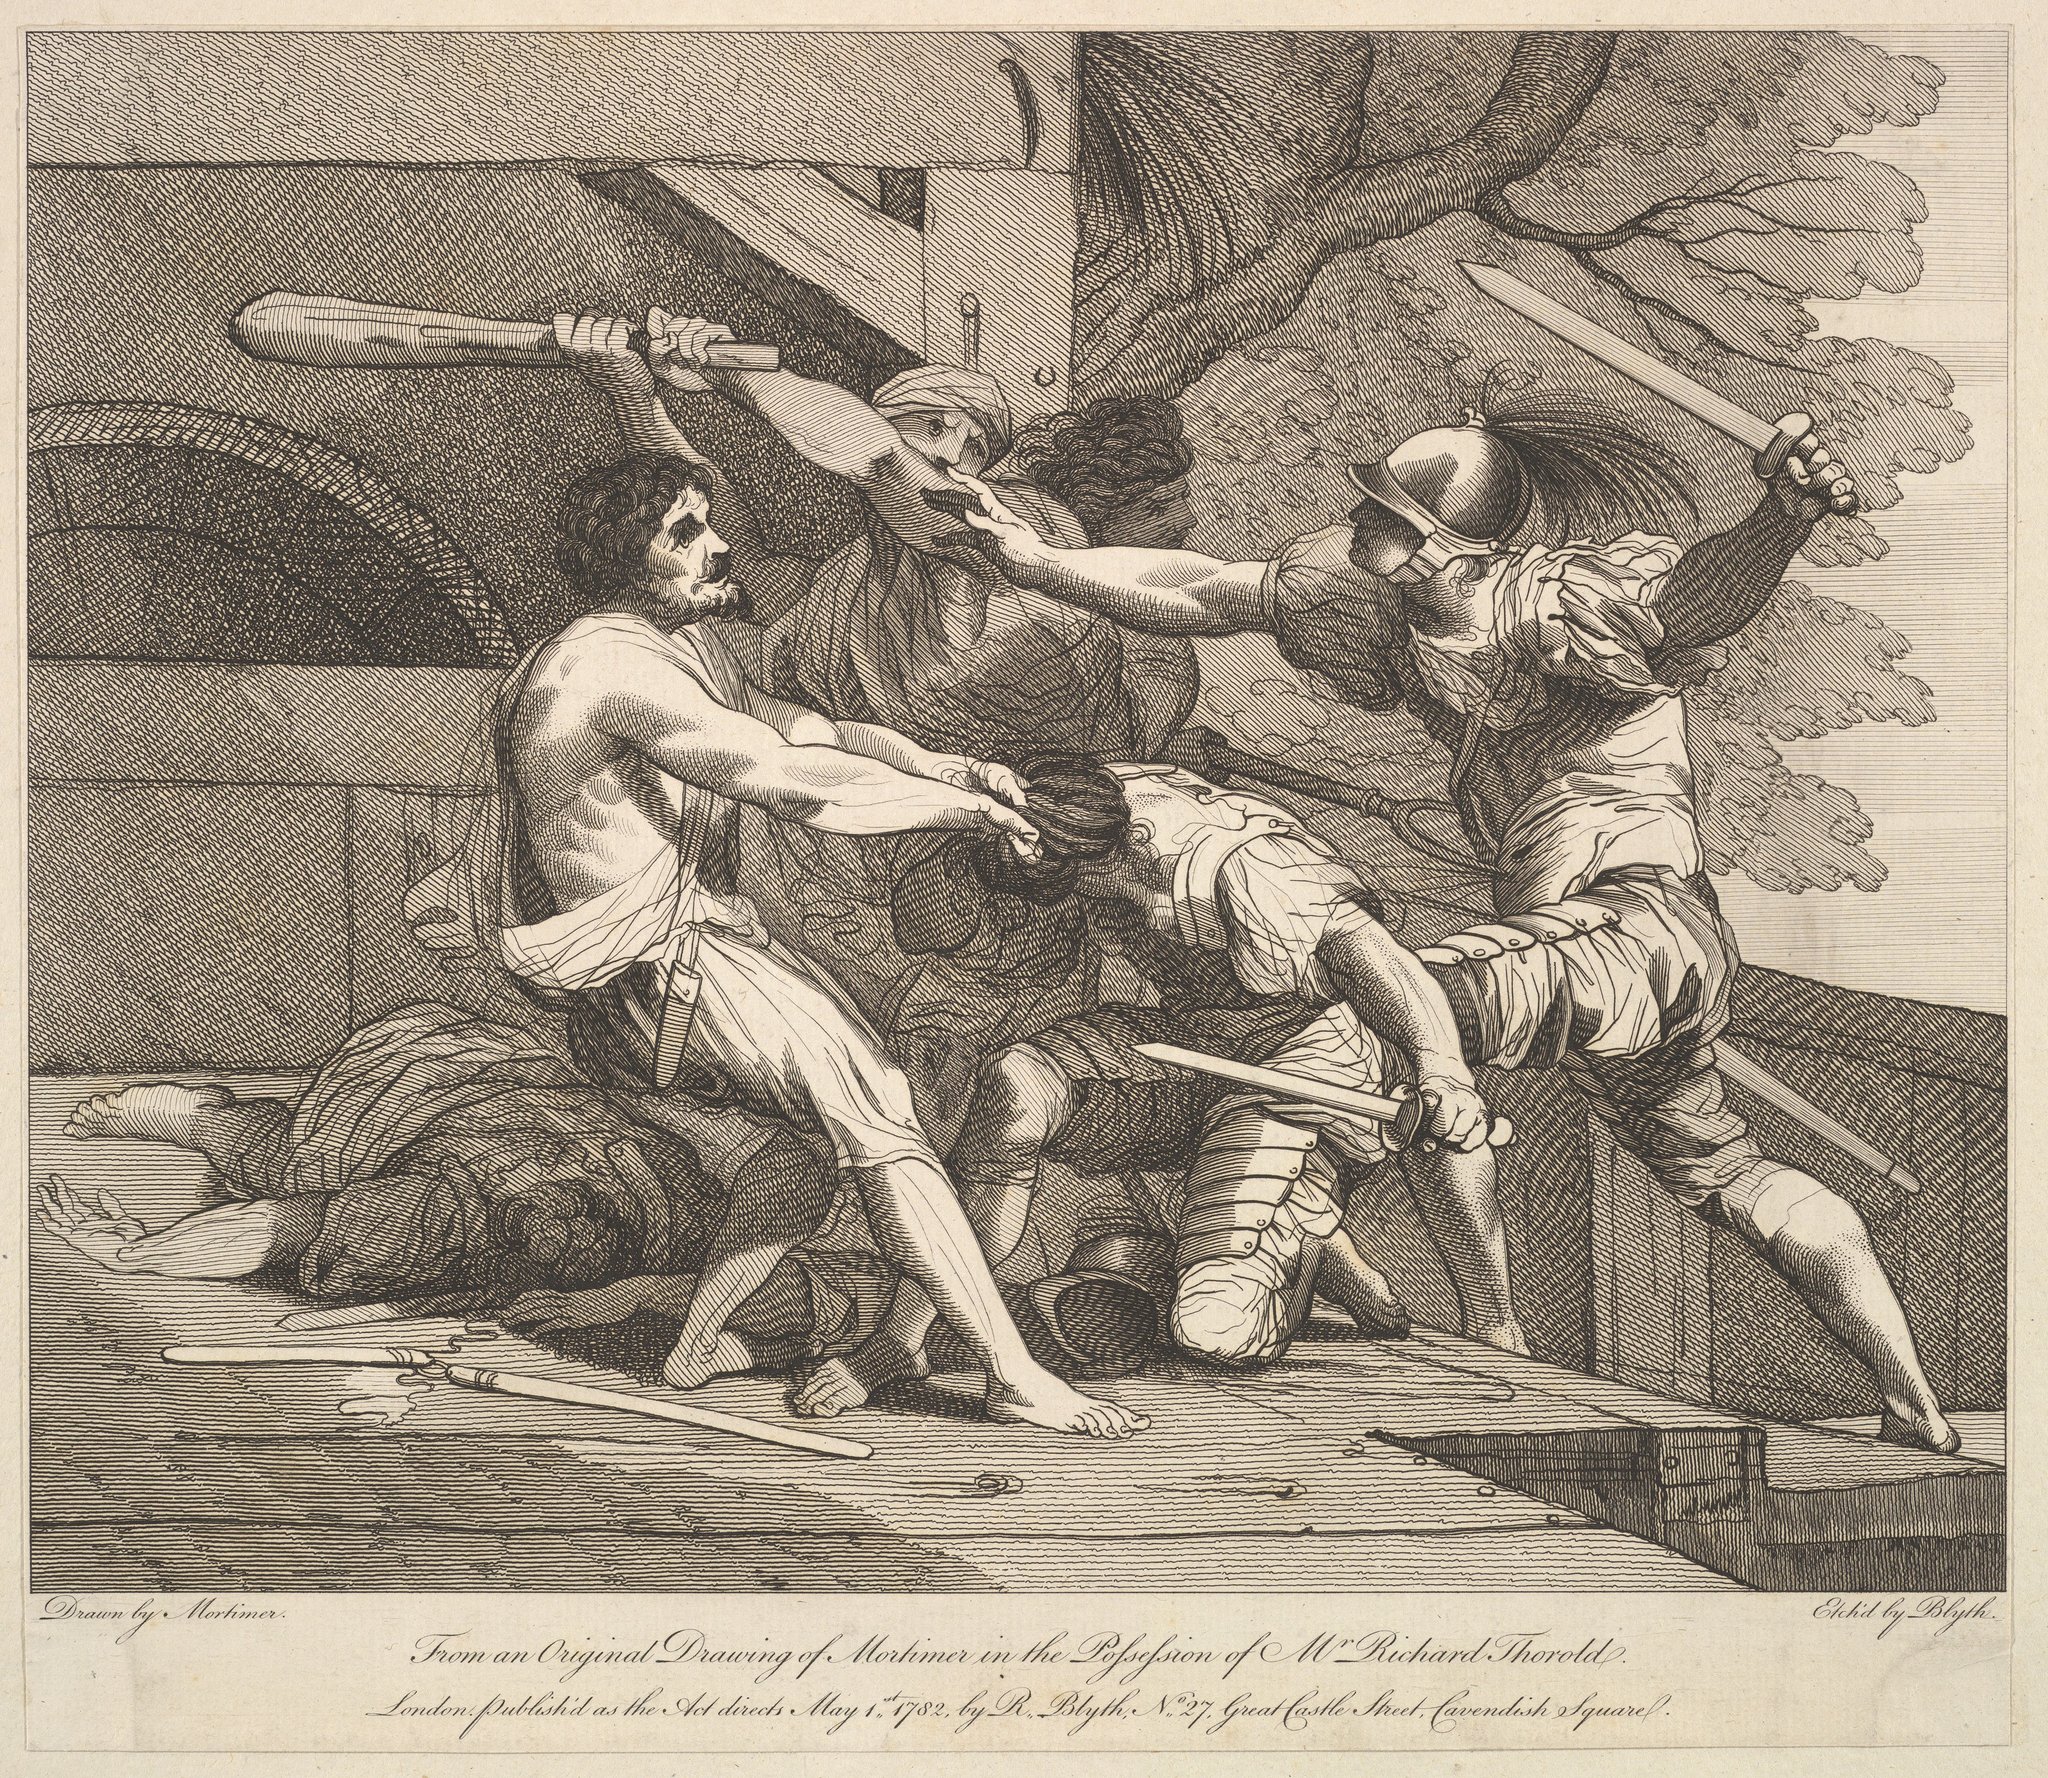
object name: print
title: Storming a Banditti Stronghold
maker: robert blyth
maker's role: artist and publisher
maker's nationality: british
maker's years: 1750-1784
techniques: etching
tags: battles,soldiers,men